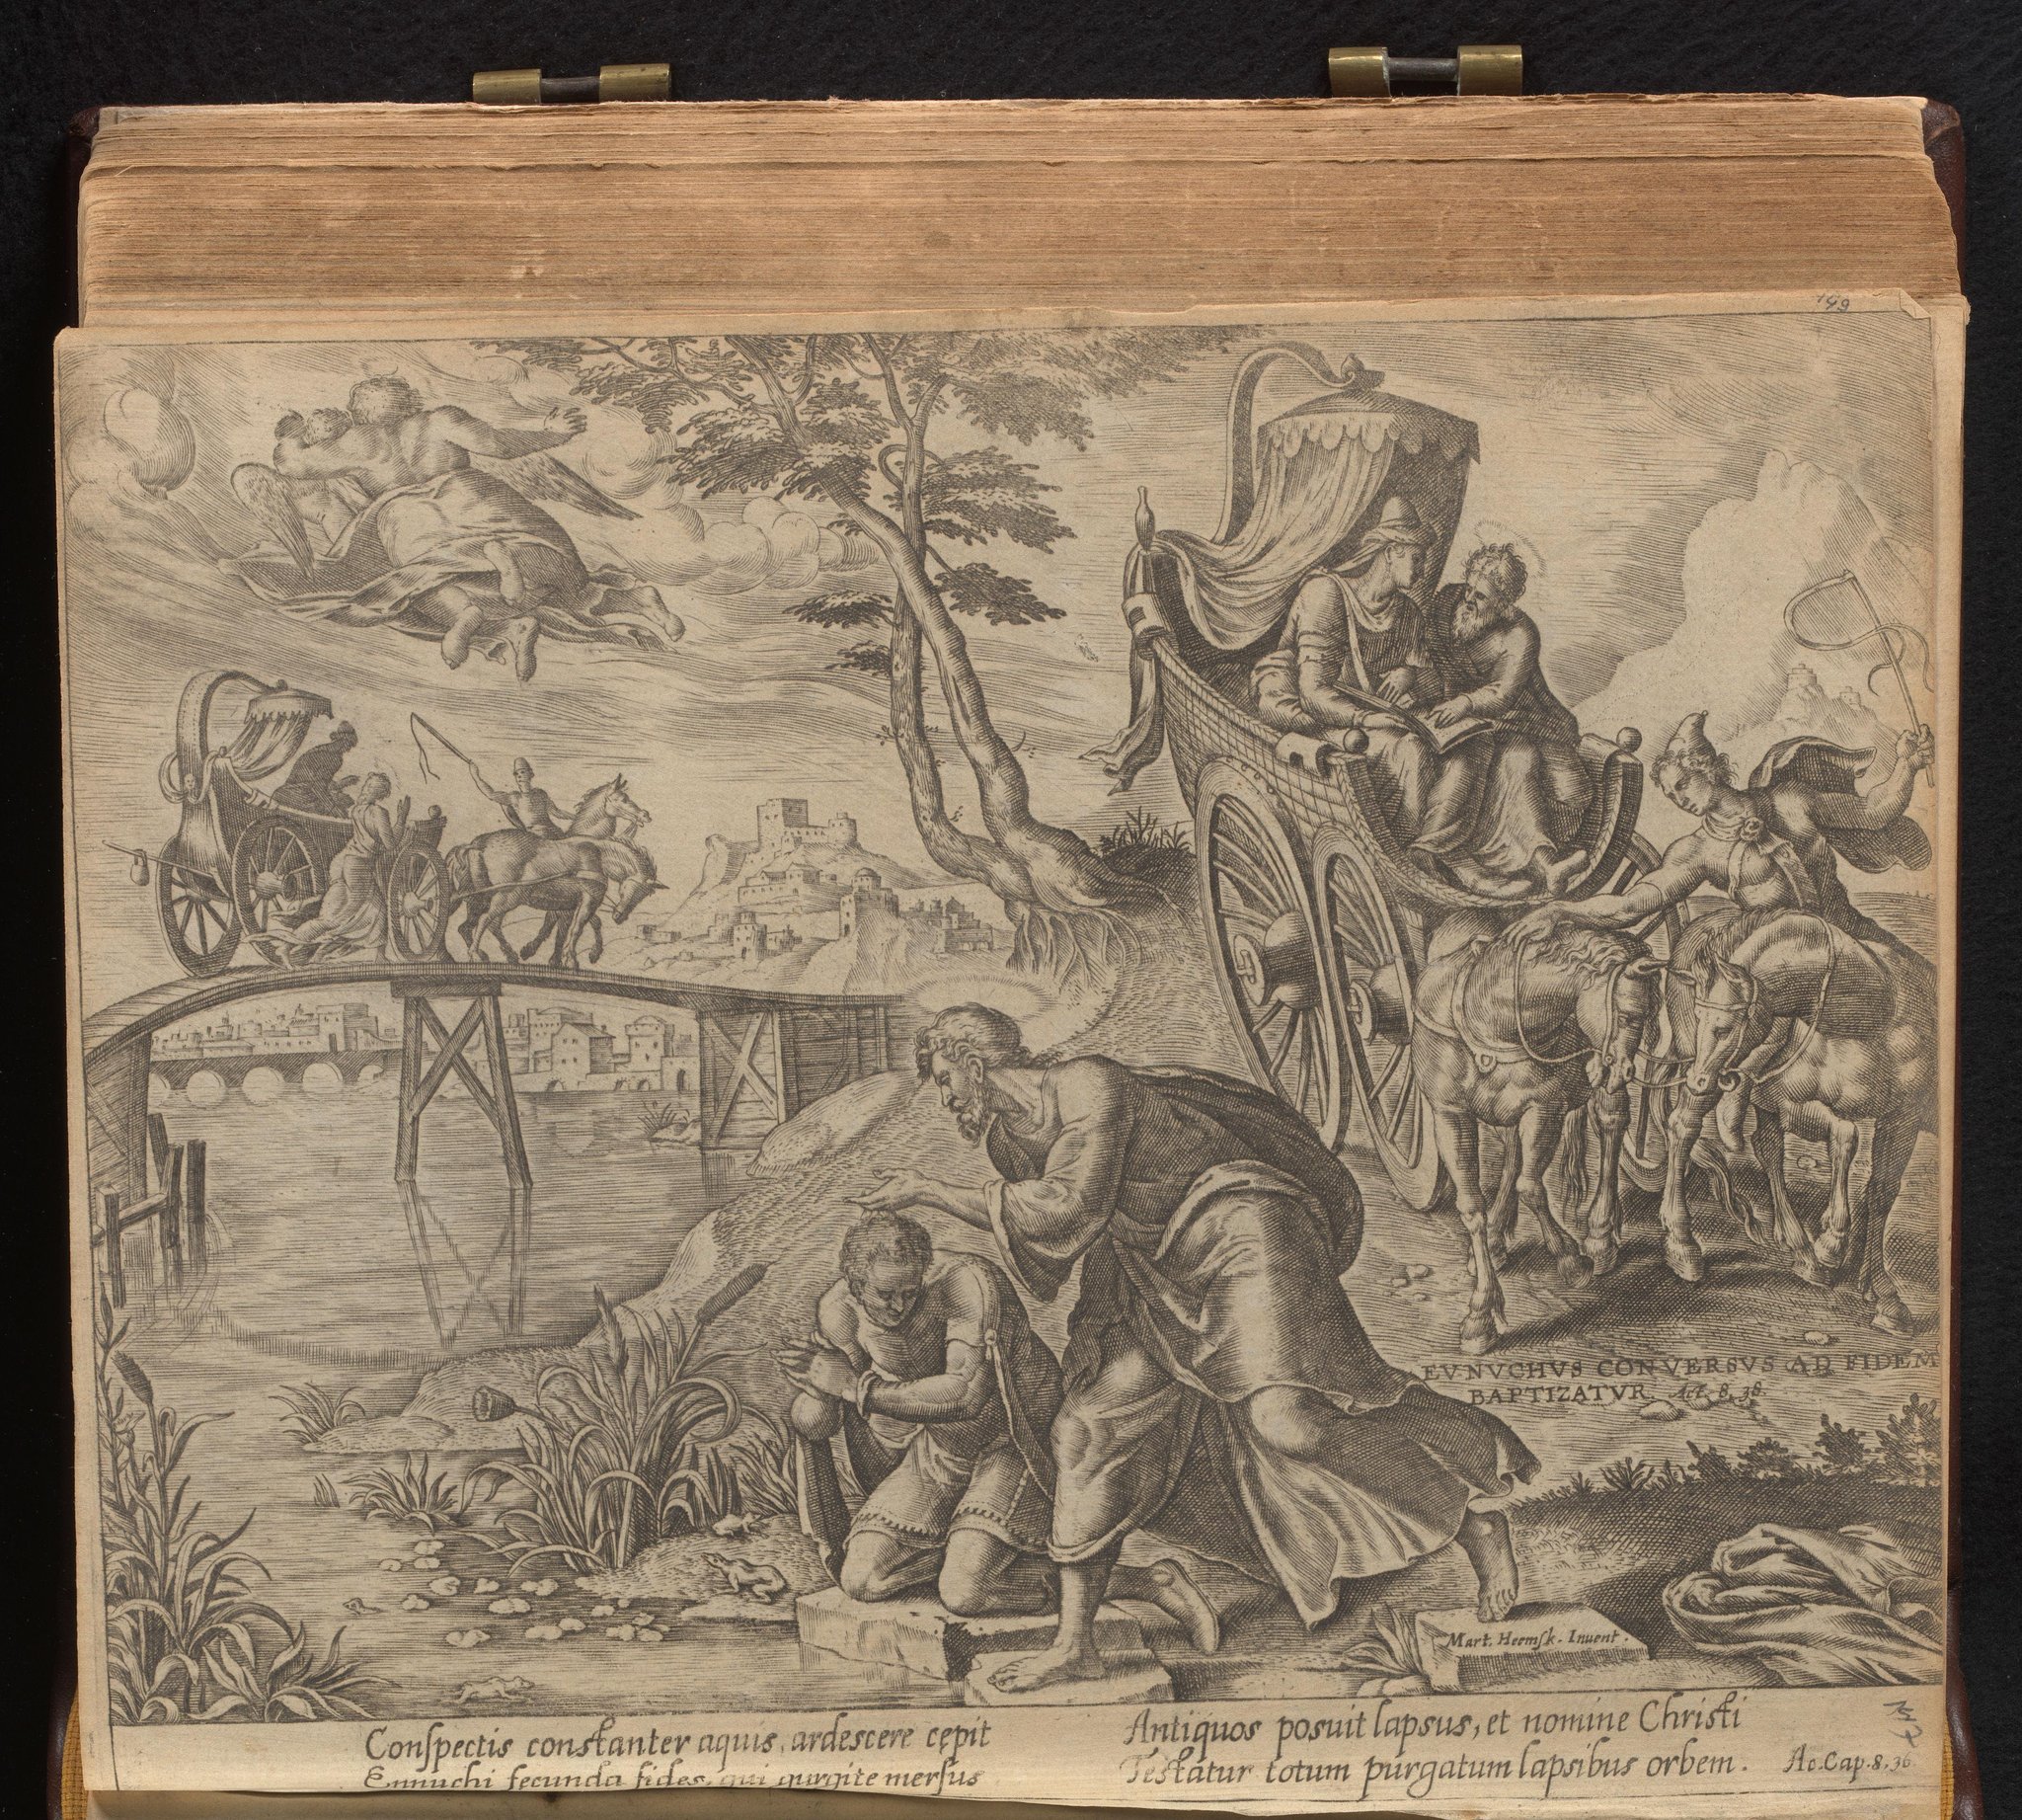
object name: album leaf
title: Filippus en de eunuch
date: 1575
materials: paper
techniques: engraving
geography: antwerp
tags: philip baptizes the eunuch, translocation of philip (by an angel), philip explains the scripture to the eunuch, philip meets the eunuch, who is travelling in a chariot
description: Prent maakt deel uit van een prentbijbel.